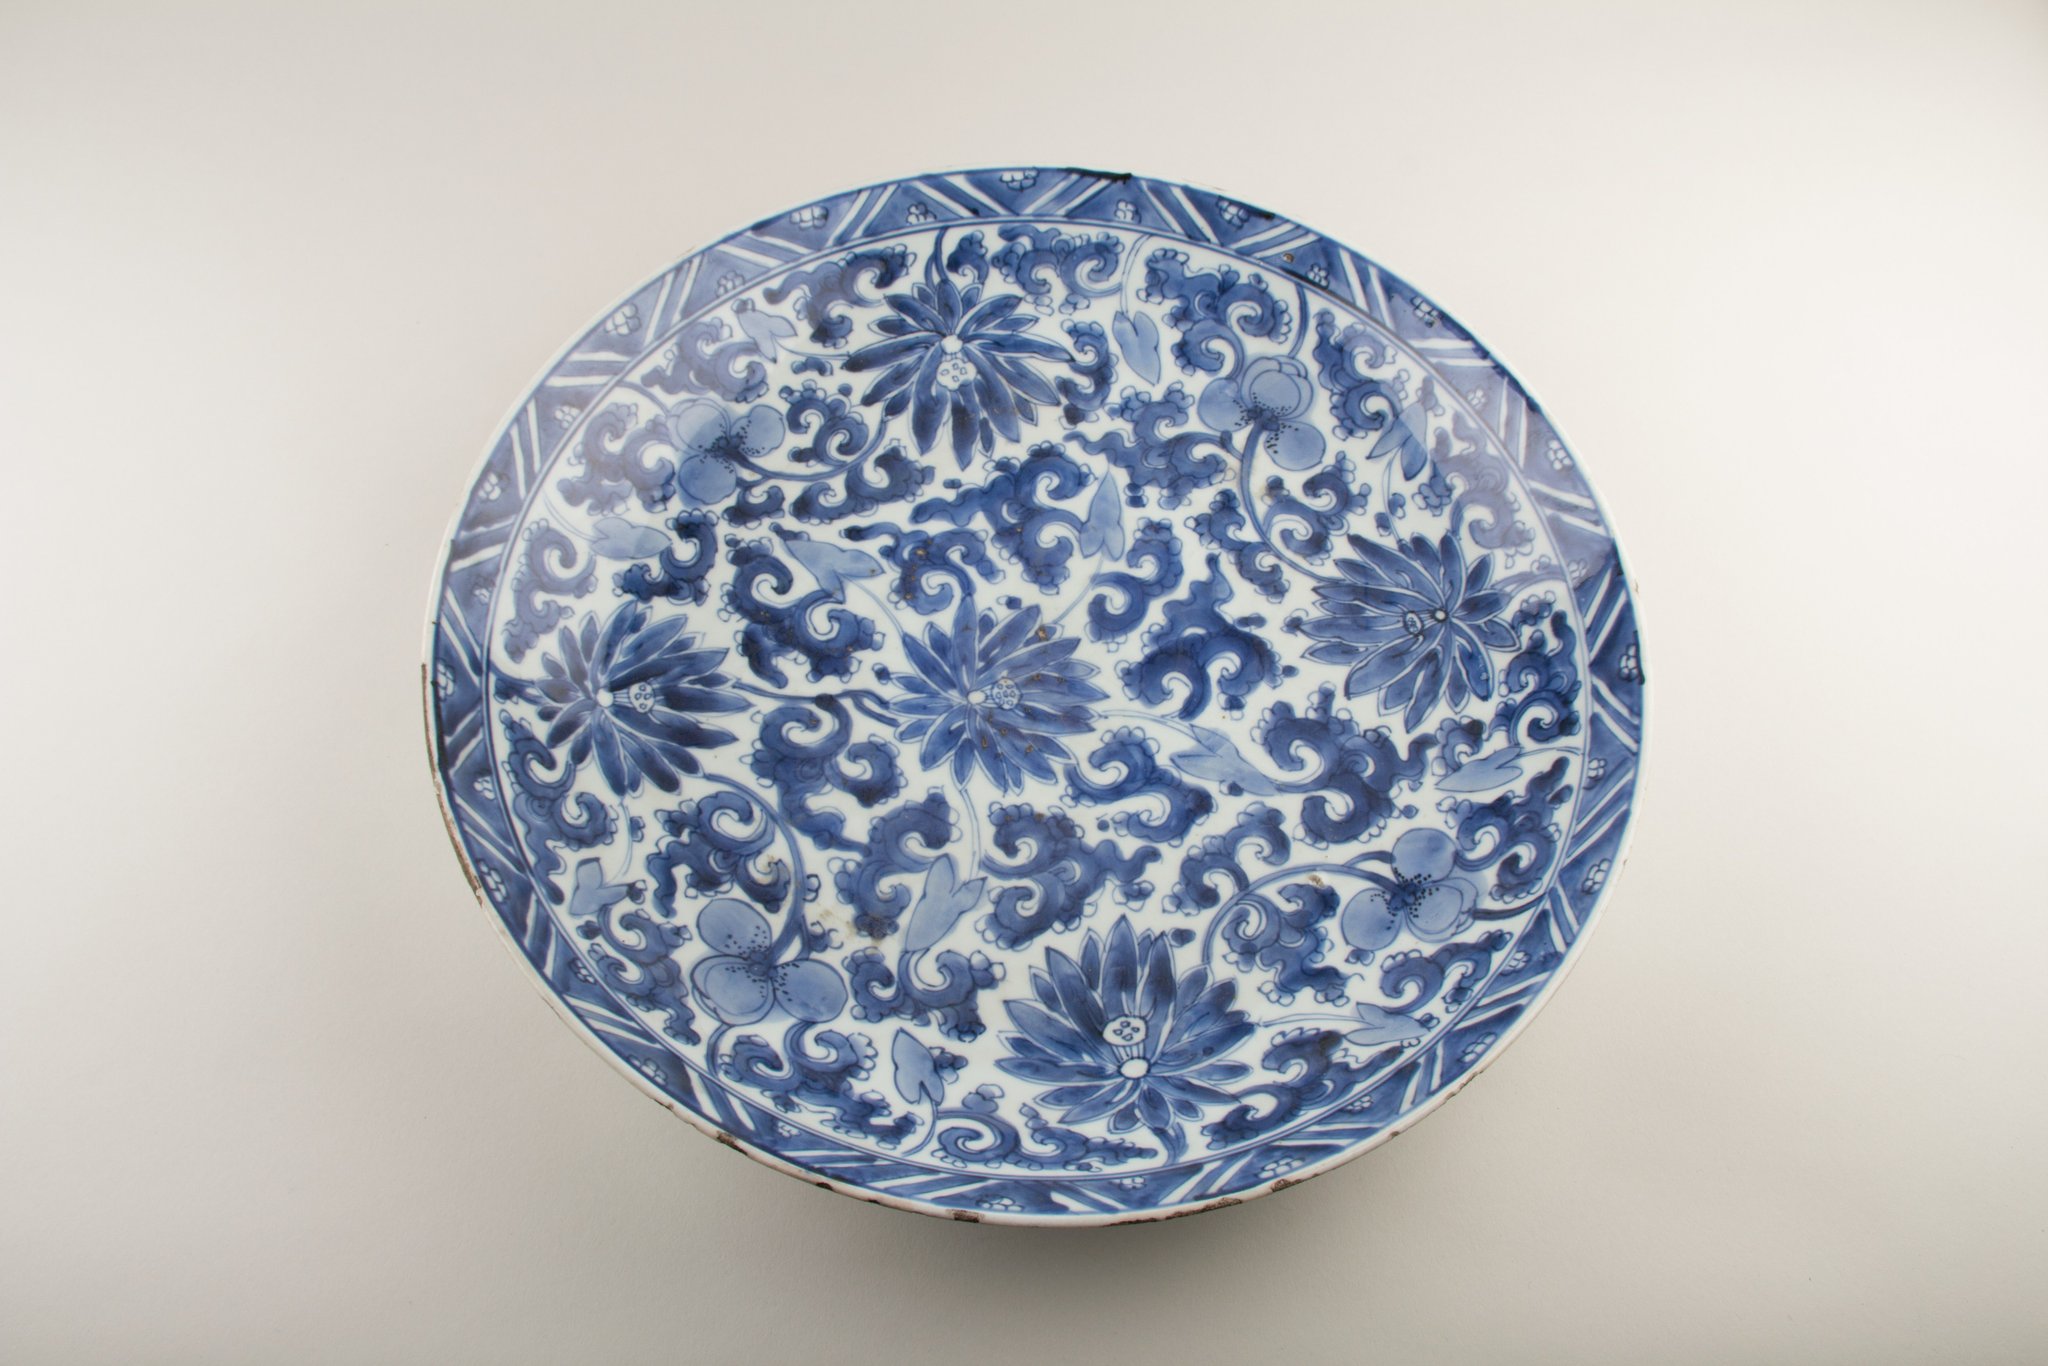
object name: plate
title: Plate with lotus scrolls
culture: chinese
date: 1667-1733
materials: cobalt, porcelain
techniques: painting, underglaze